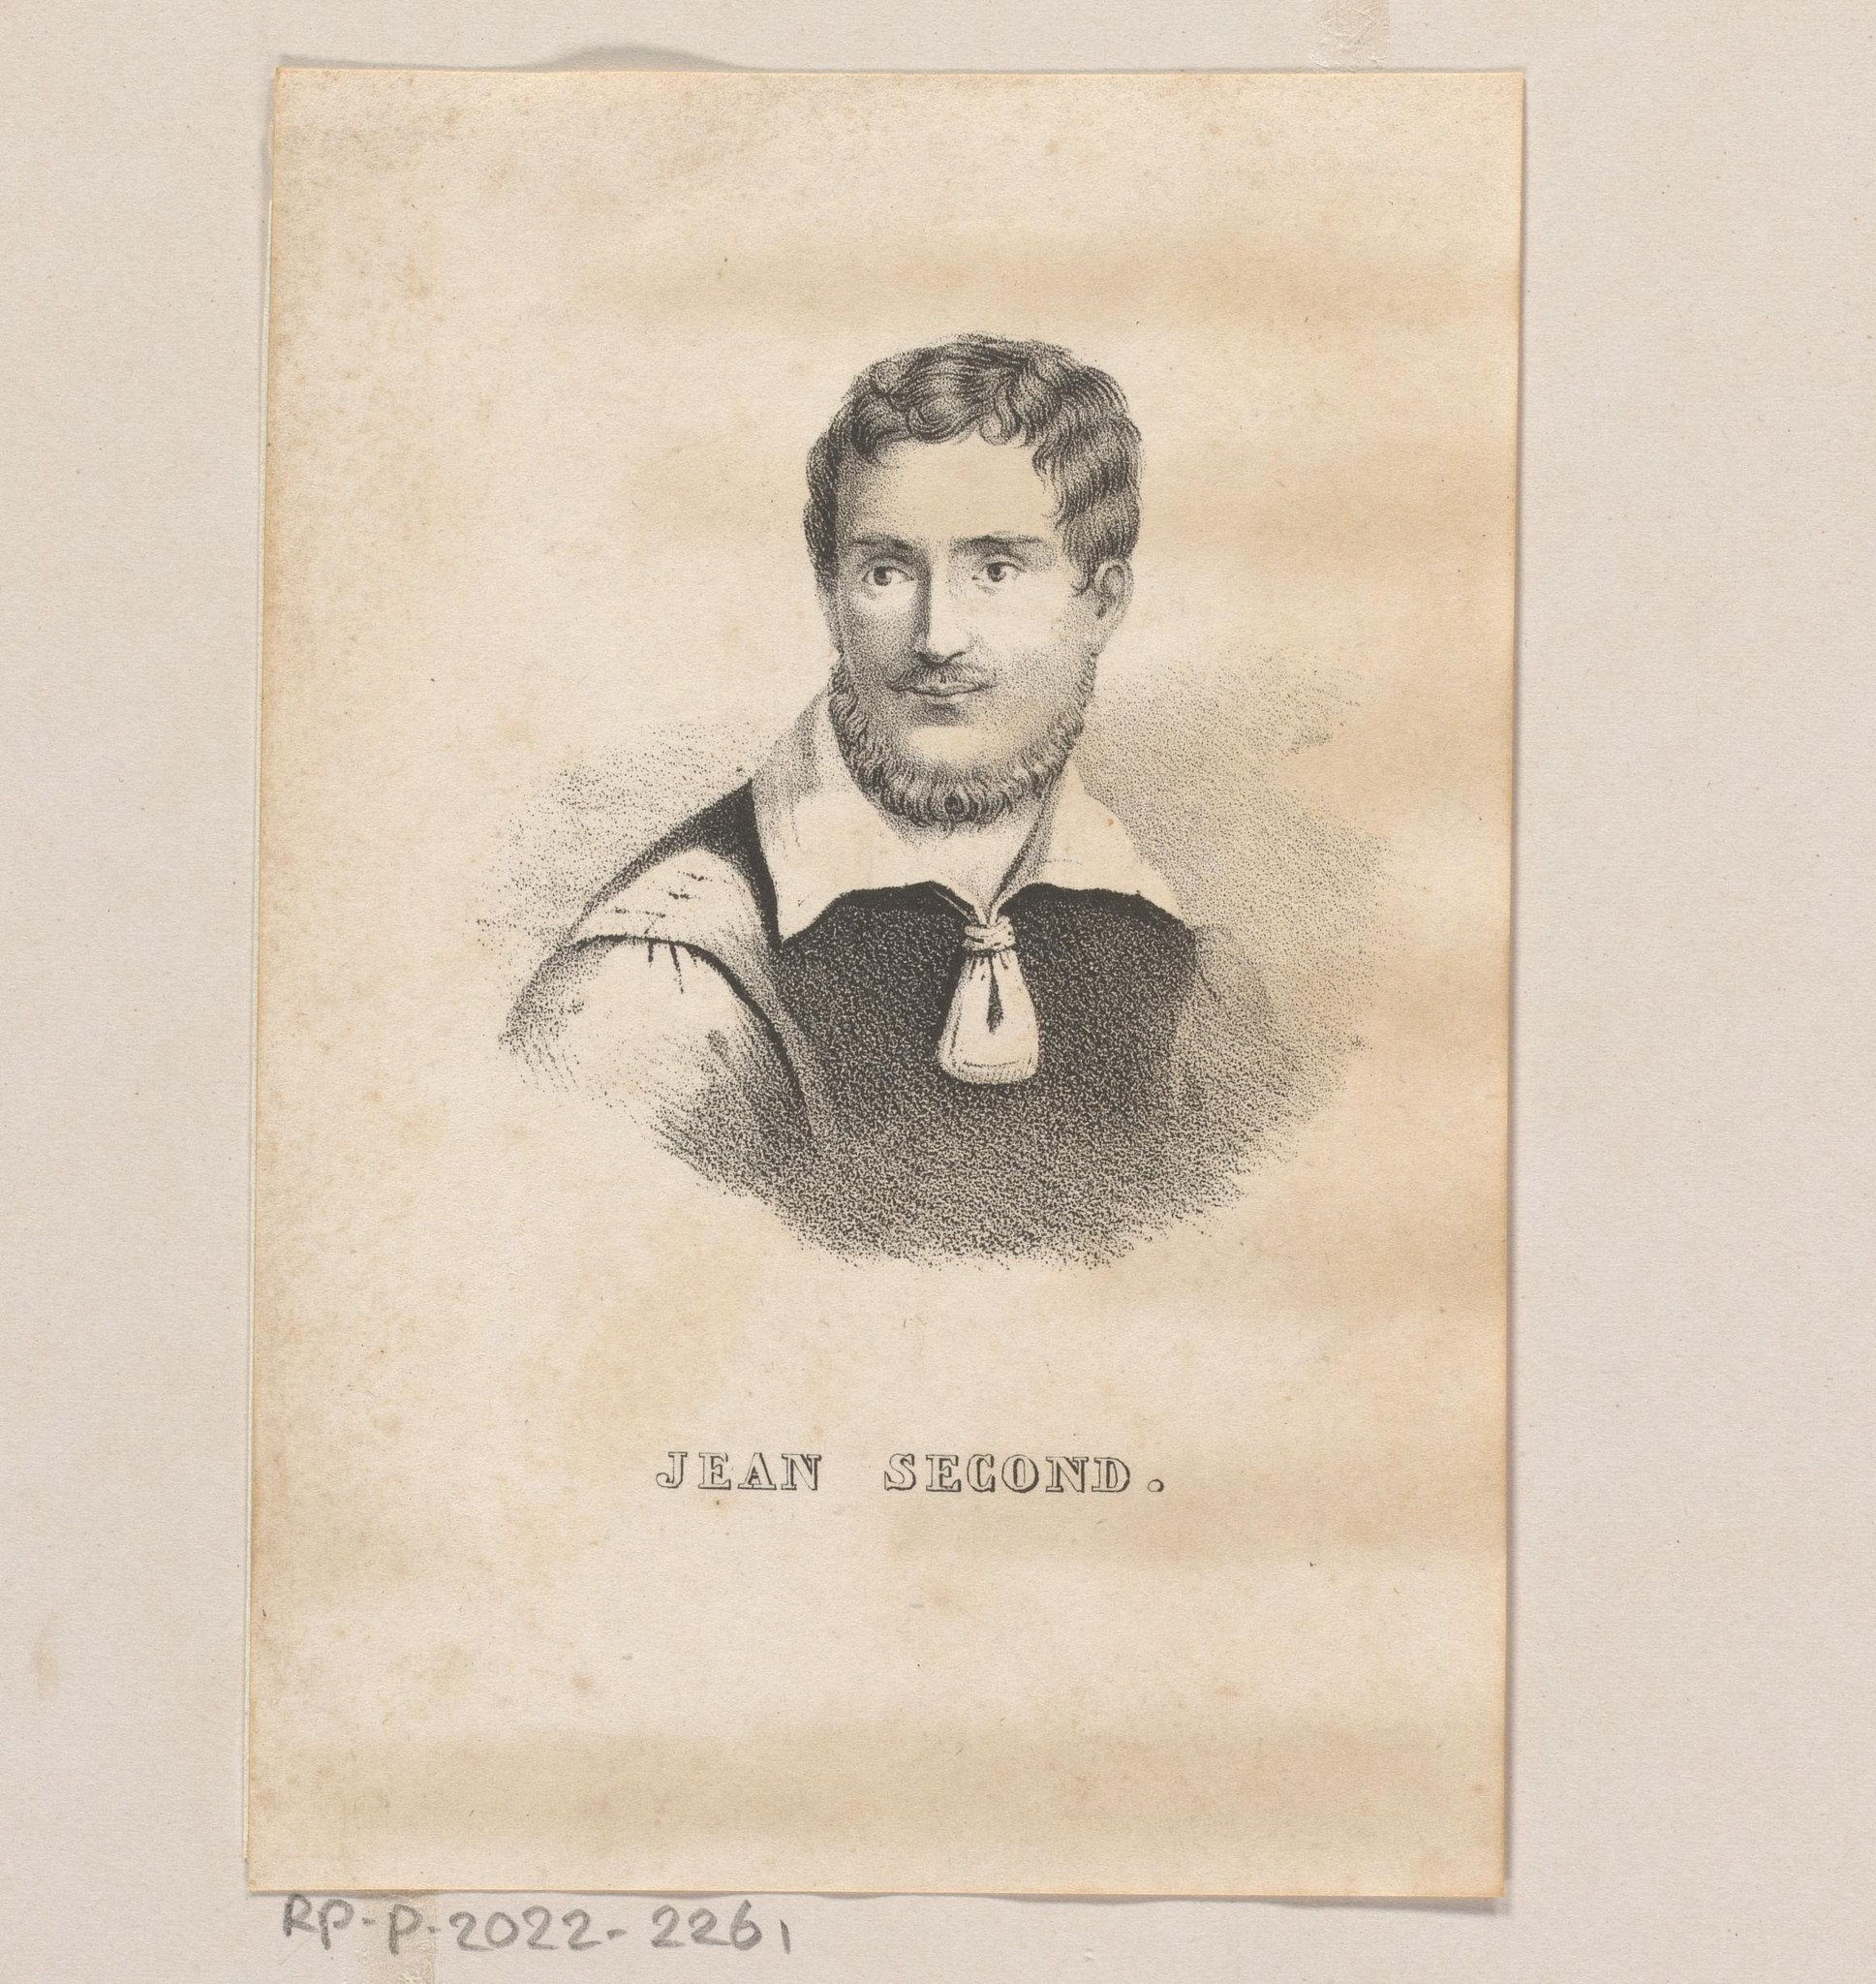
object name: print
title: Jean Second.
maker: Anonymous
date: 1798-1899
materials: paper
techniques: lithograph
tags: the hague, janus secundus, historical persons, portrait of a writer, writer, poet, author